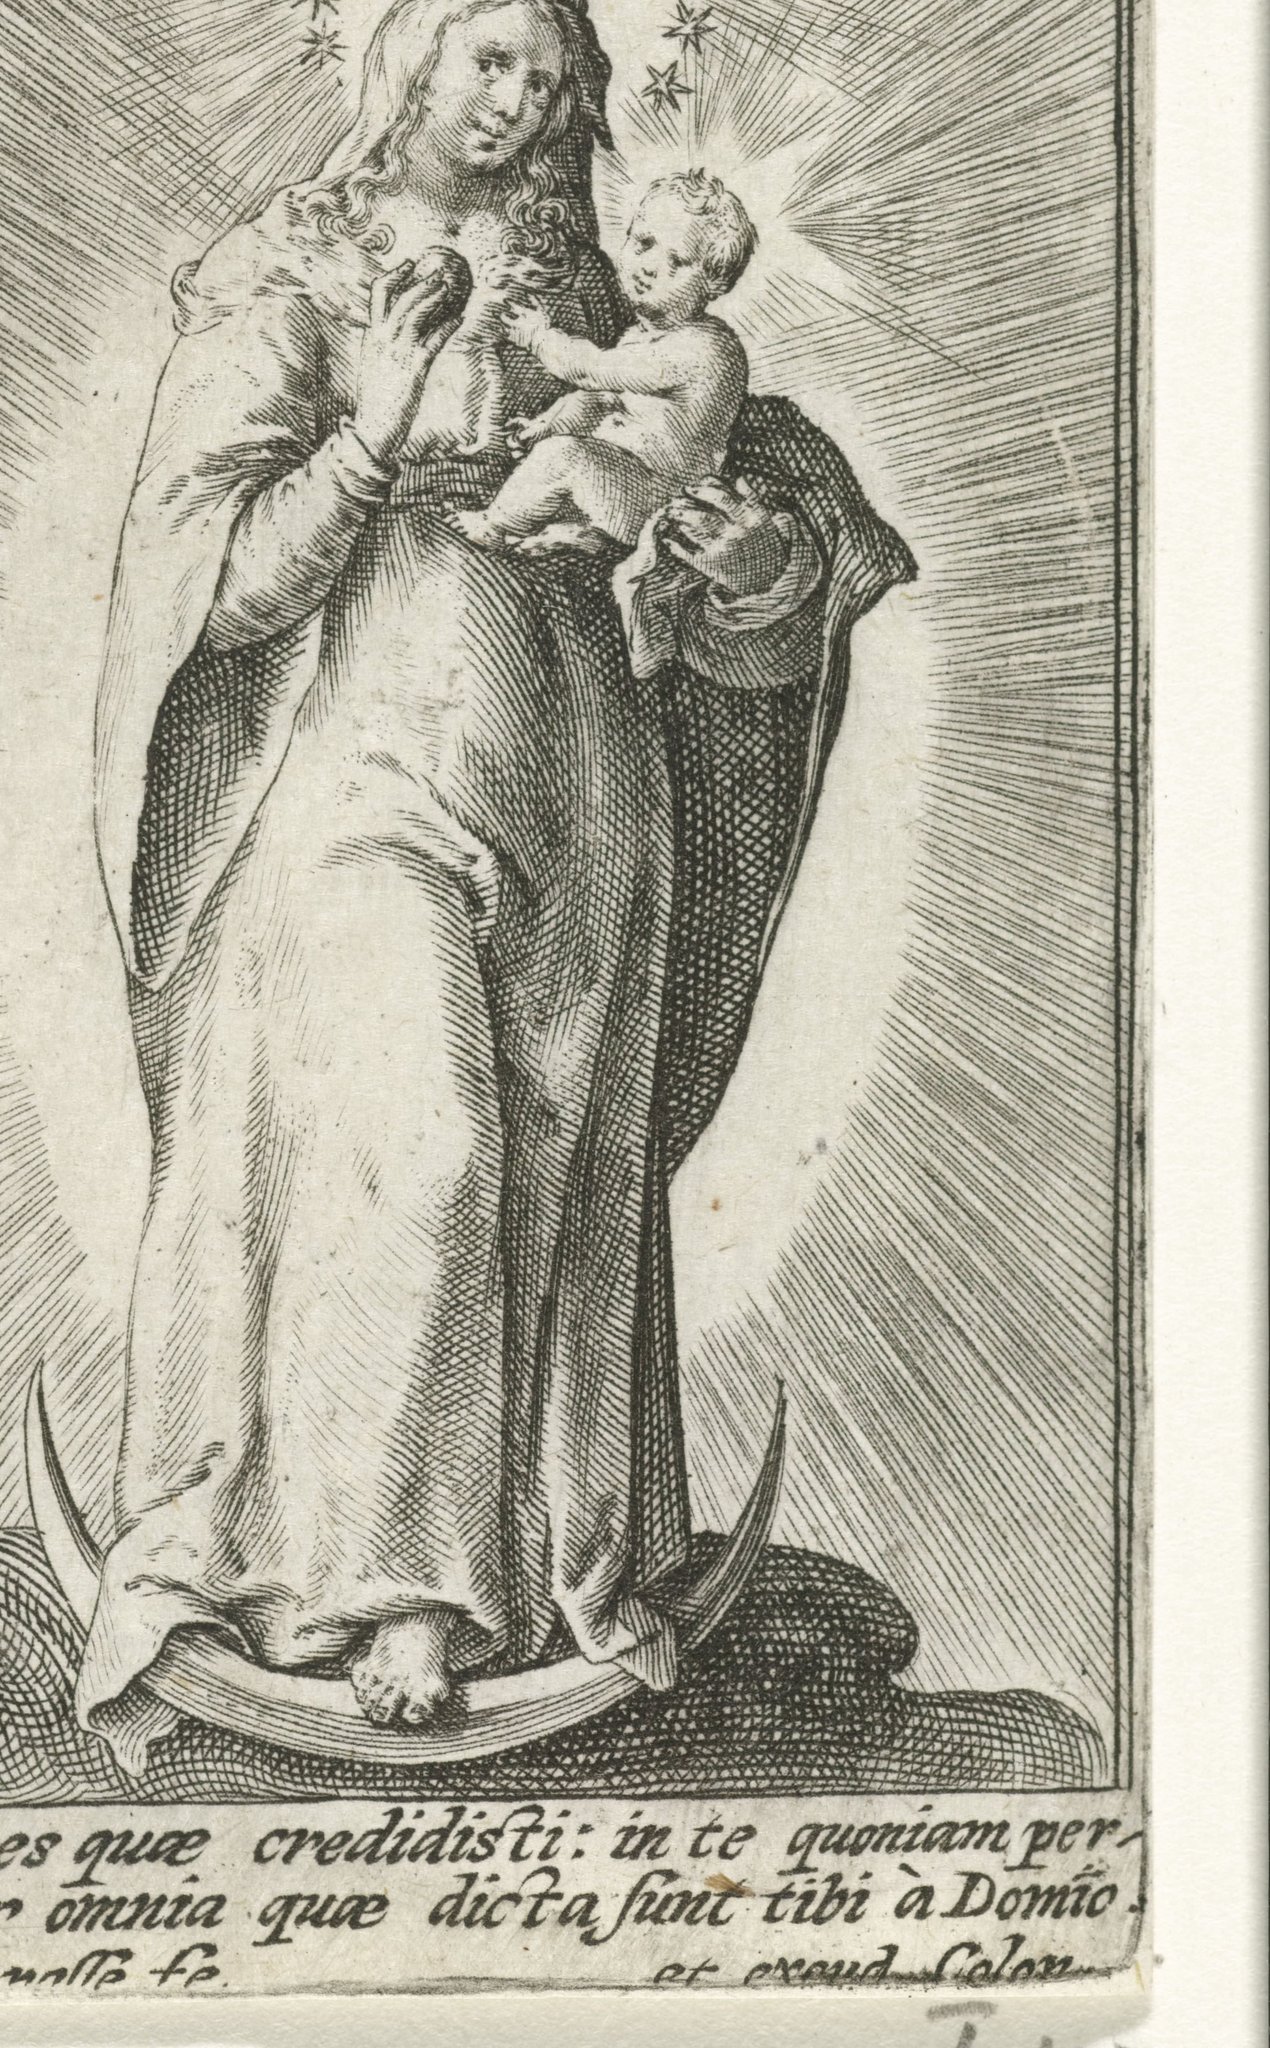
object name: print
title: De twaalf apostelen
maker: crispijn van de passe (i)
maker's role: draughtsman, print maker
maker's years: 1564-1637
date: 1574-1637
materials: paper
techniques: engraving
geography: cologne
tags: madonna on the crescent of the moon (sometimes called queen of heaven) (in mandorla)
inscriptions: collector's mark: Lugt 240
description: Gekroonde Maria met het Christuskind op een maansikkel. In haar rechterhand een appel. In de marge een tweeregelig onderschrift in het Latijn. Prent maakt deel uit van een serie met de twaalf apostelen.